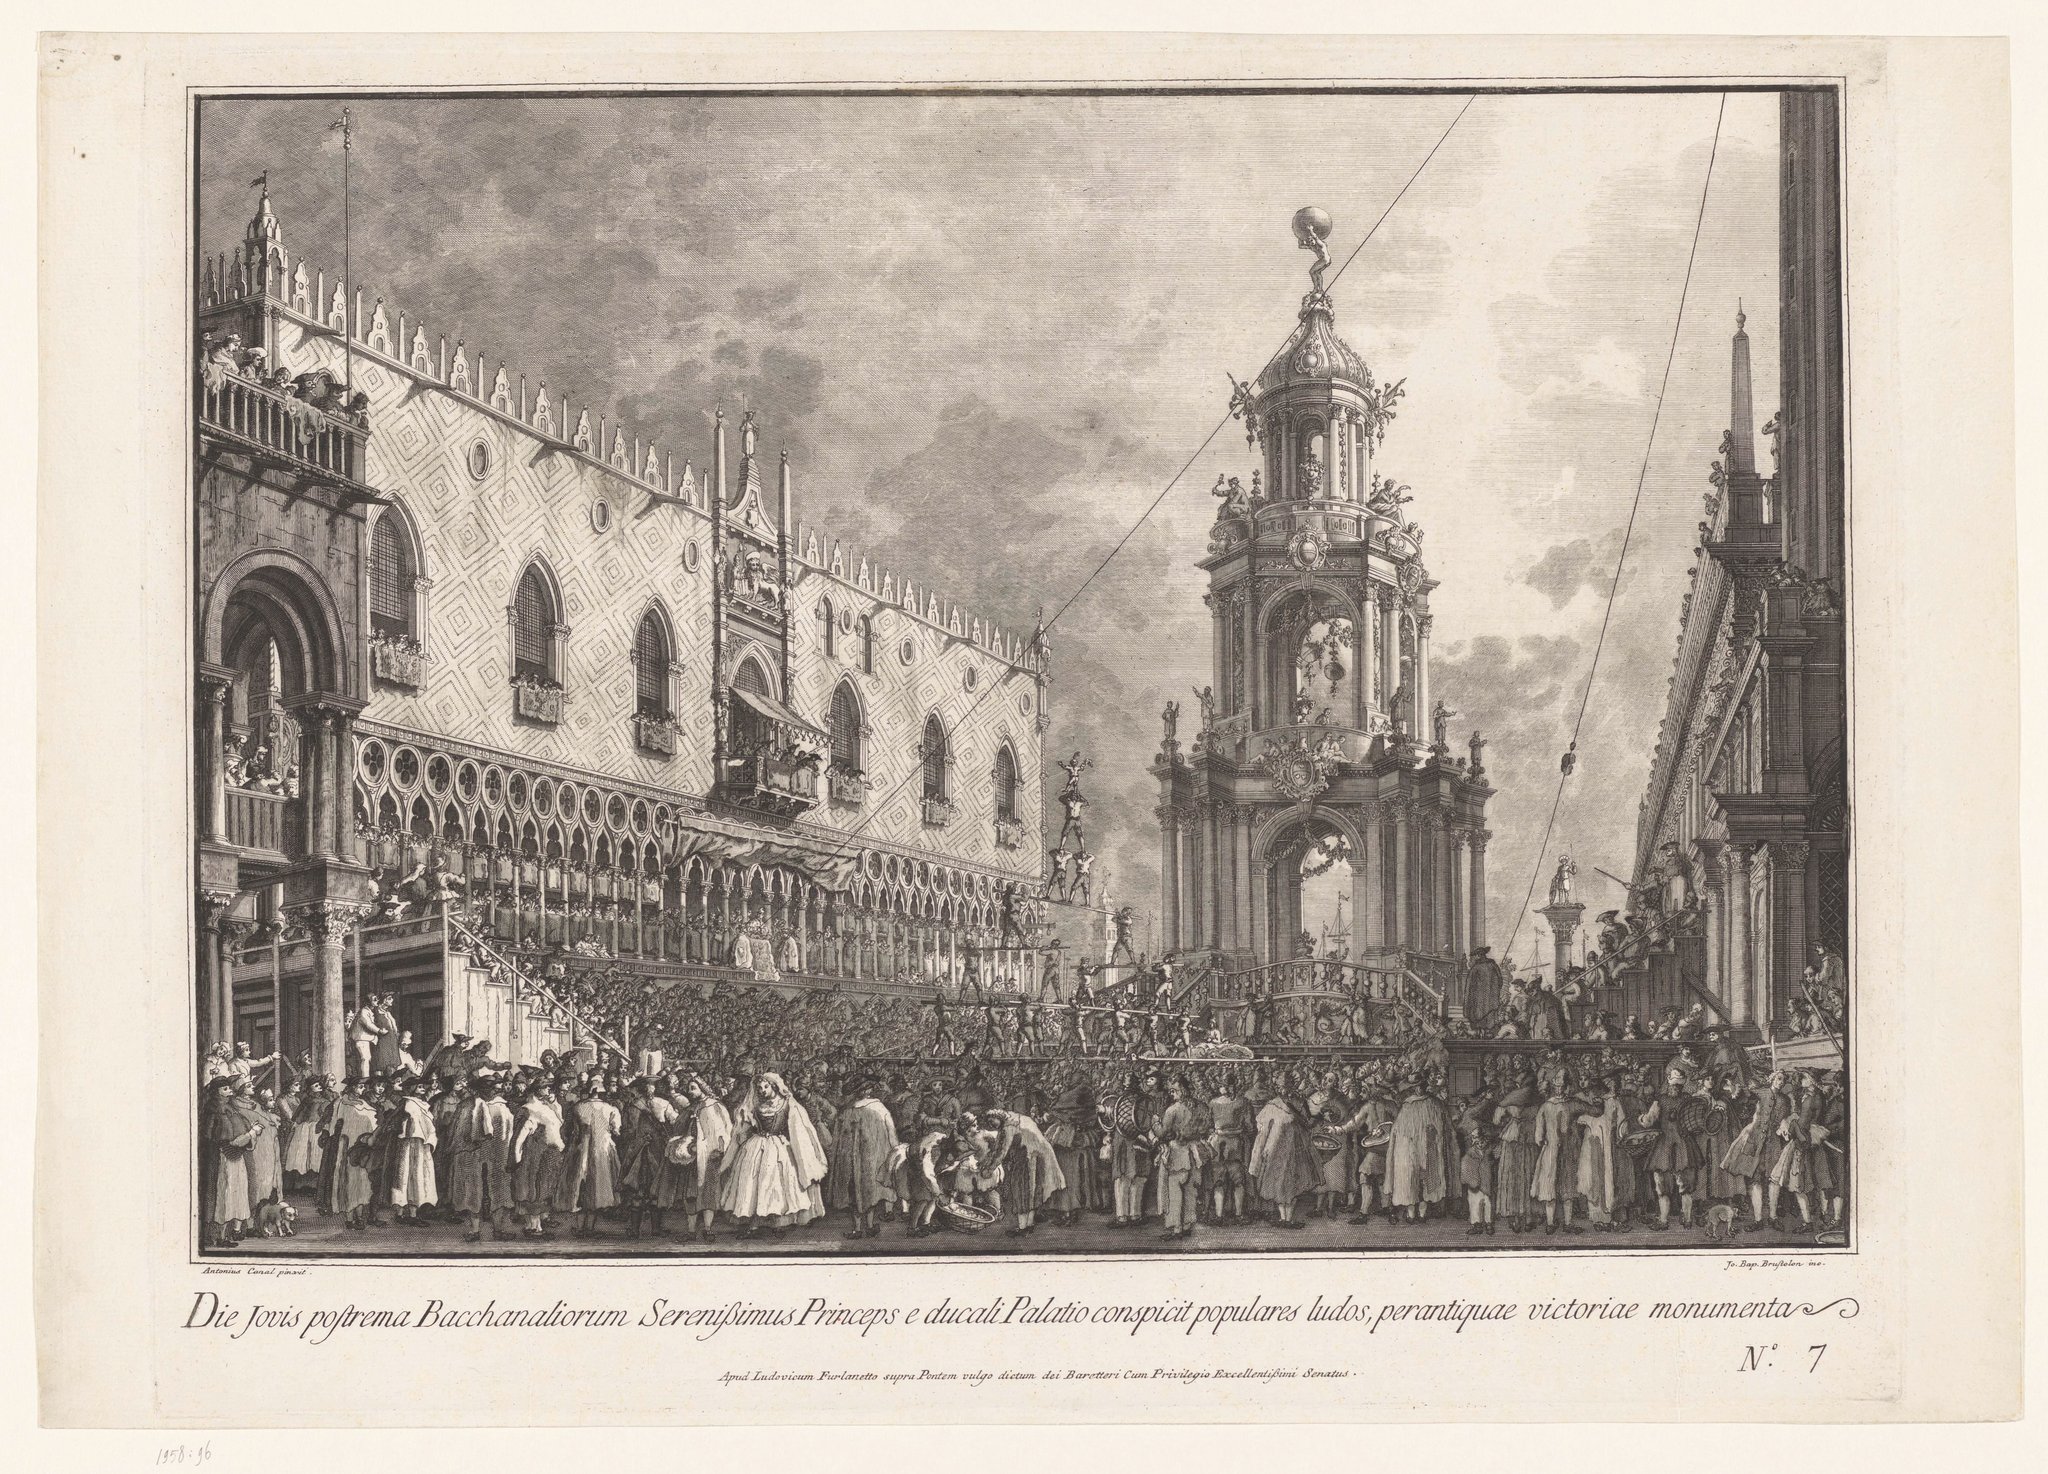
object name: print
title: Acrobaten voor het Dogepaleis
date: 1766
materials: paper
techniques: etching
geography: italy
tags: square, place, circus, etc., acrobat ~ circus, public festivities, other sovereign: doge, venice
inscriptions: collector's mark: Lugt 2760, collector's mark: Lugt 2228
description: Gezicht op het Piazza San Marco te Venetië met links het Dogepaleis. Op het plein vinden festiviteiten plaats. Acrobaten vormen een menselijke piramide. De Doge van Venetië kijkt toe vanaf zijn troon op het balkon van het Dogenpaleis.